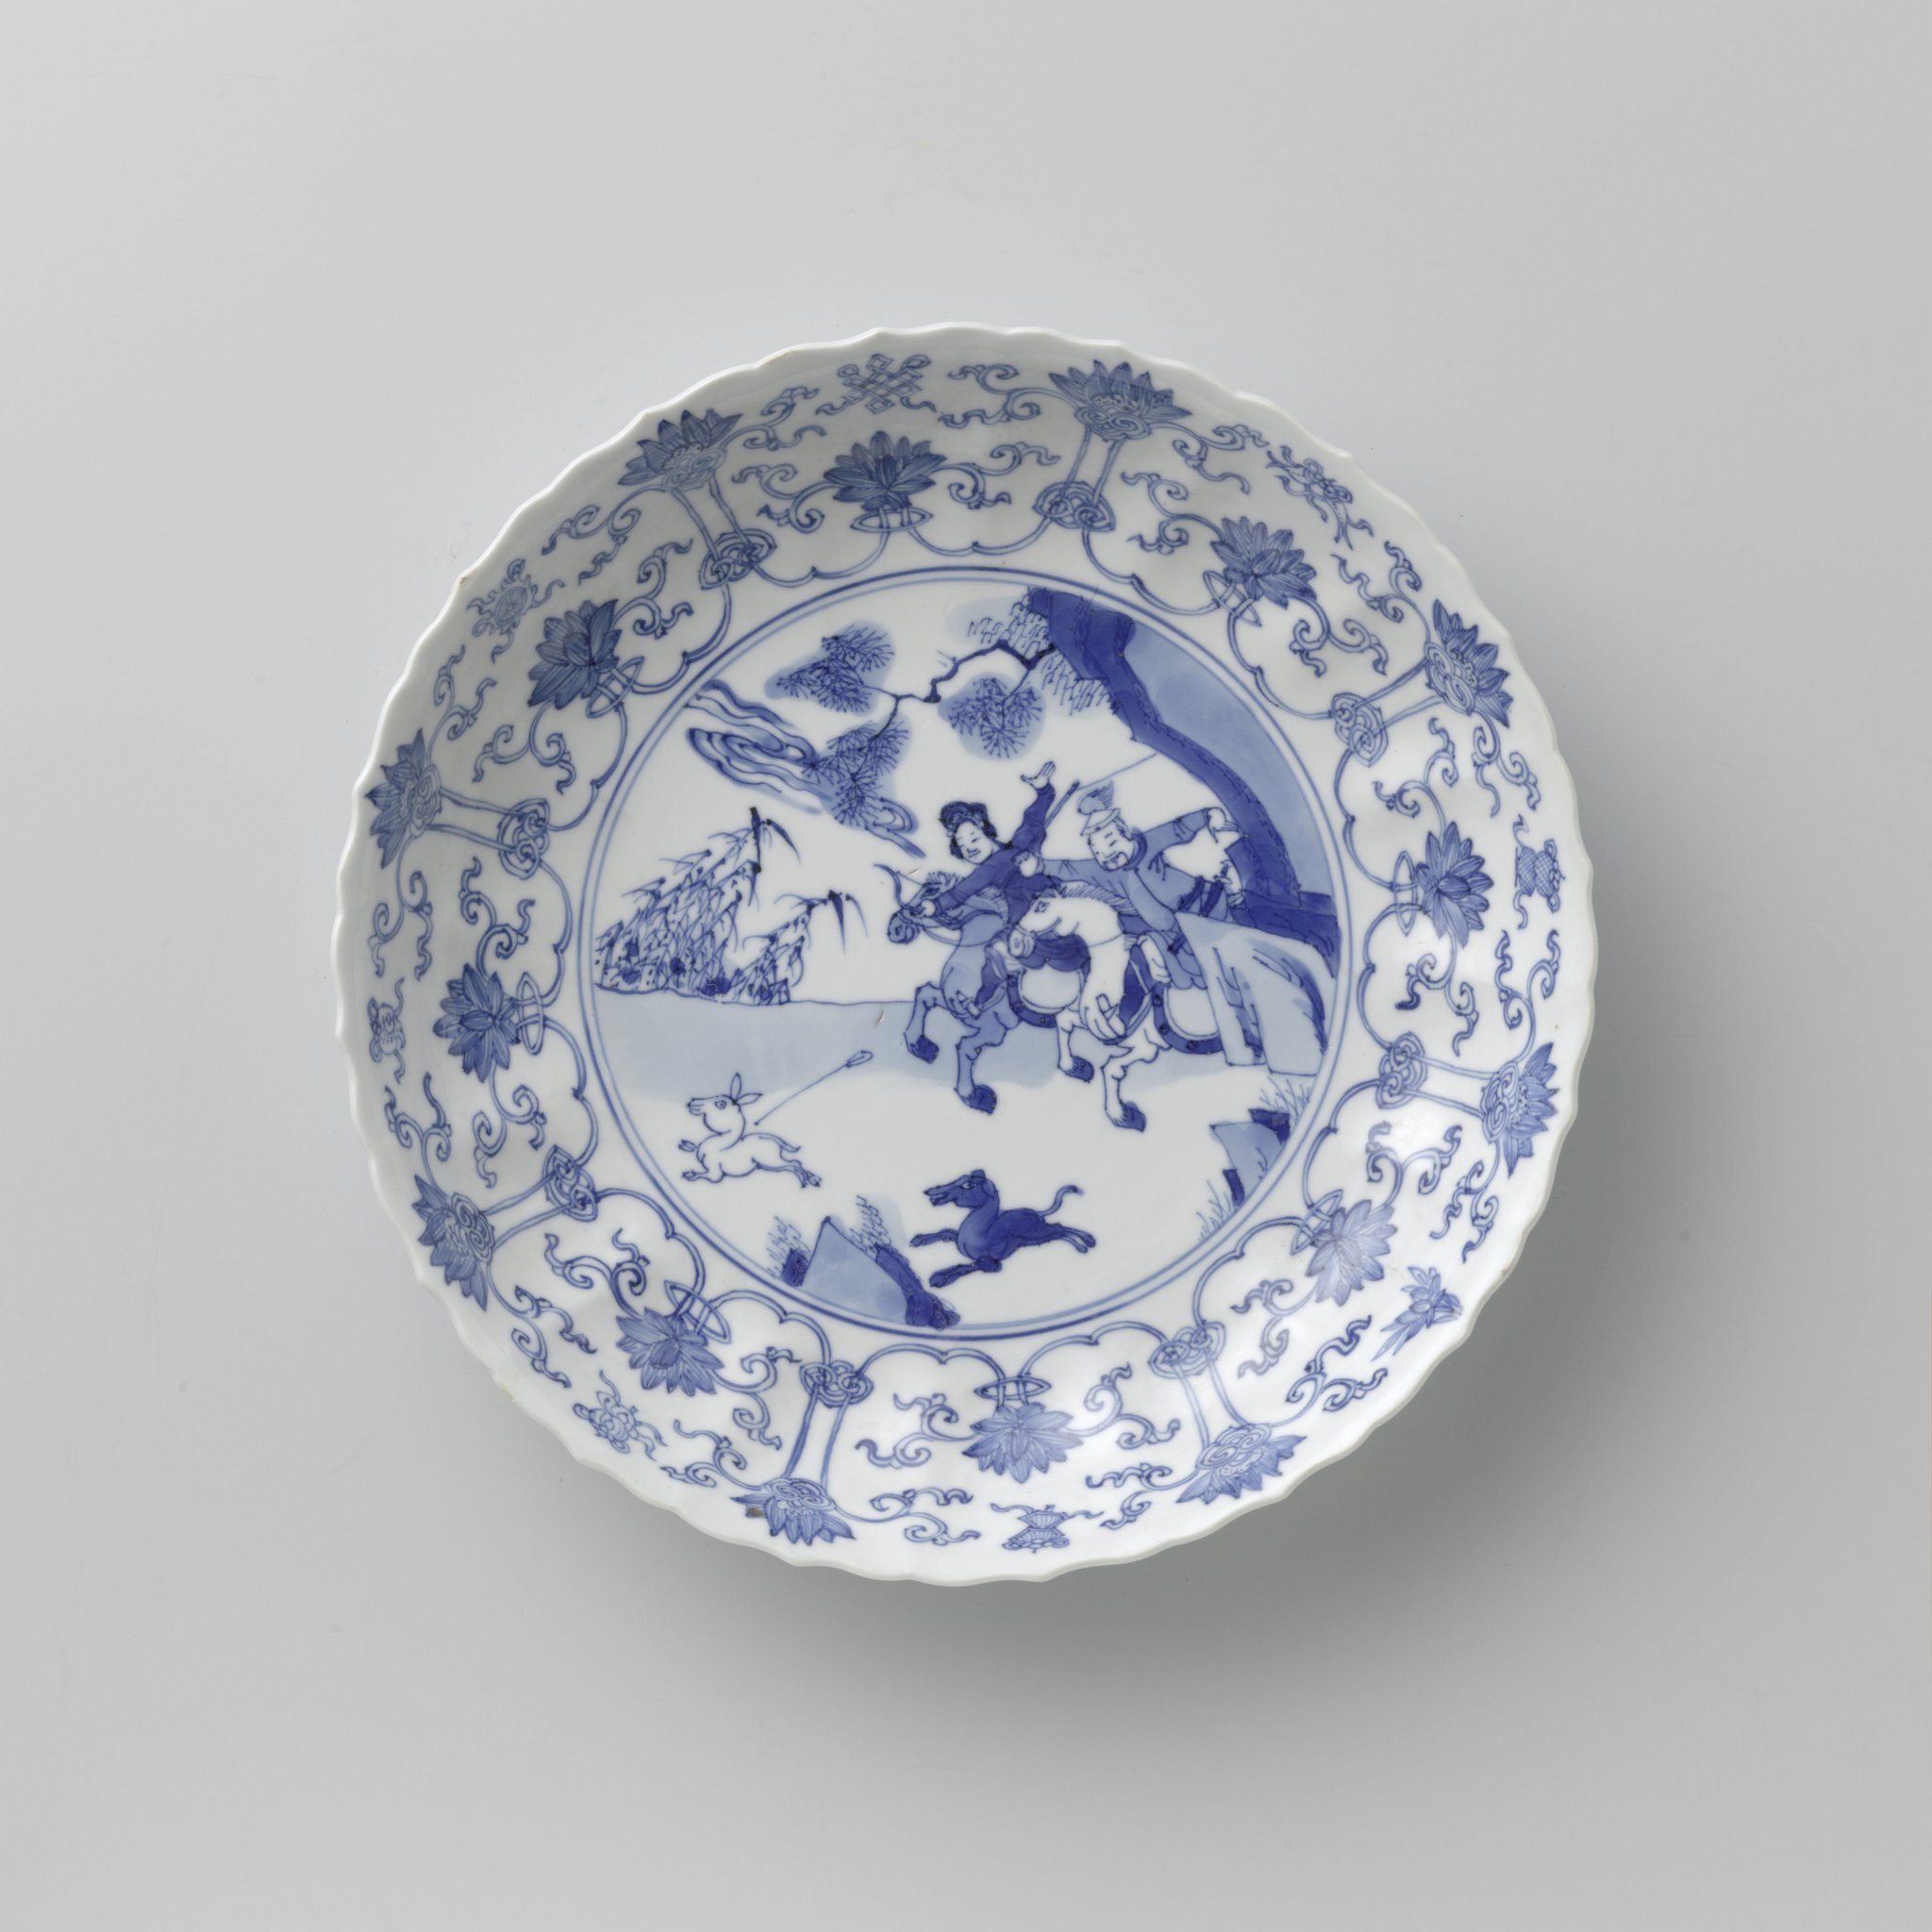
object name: dish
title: Saucer-dish with hunting scene, lotus scrolls and auspicious symbols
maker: Anonymous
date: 1700-1724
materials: cobalt, glaze, paint, porcelain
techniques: firing, forming, turning, vitrification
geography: china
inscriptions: mark: ‘大 明 成 化 年 製 dà míng Chéng huà nián zhì’